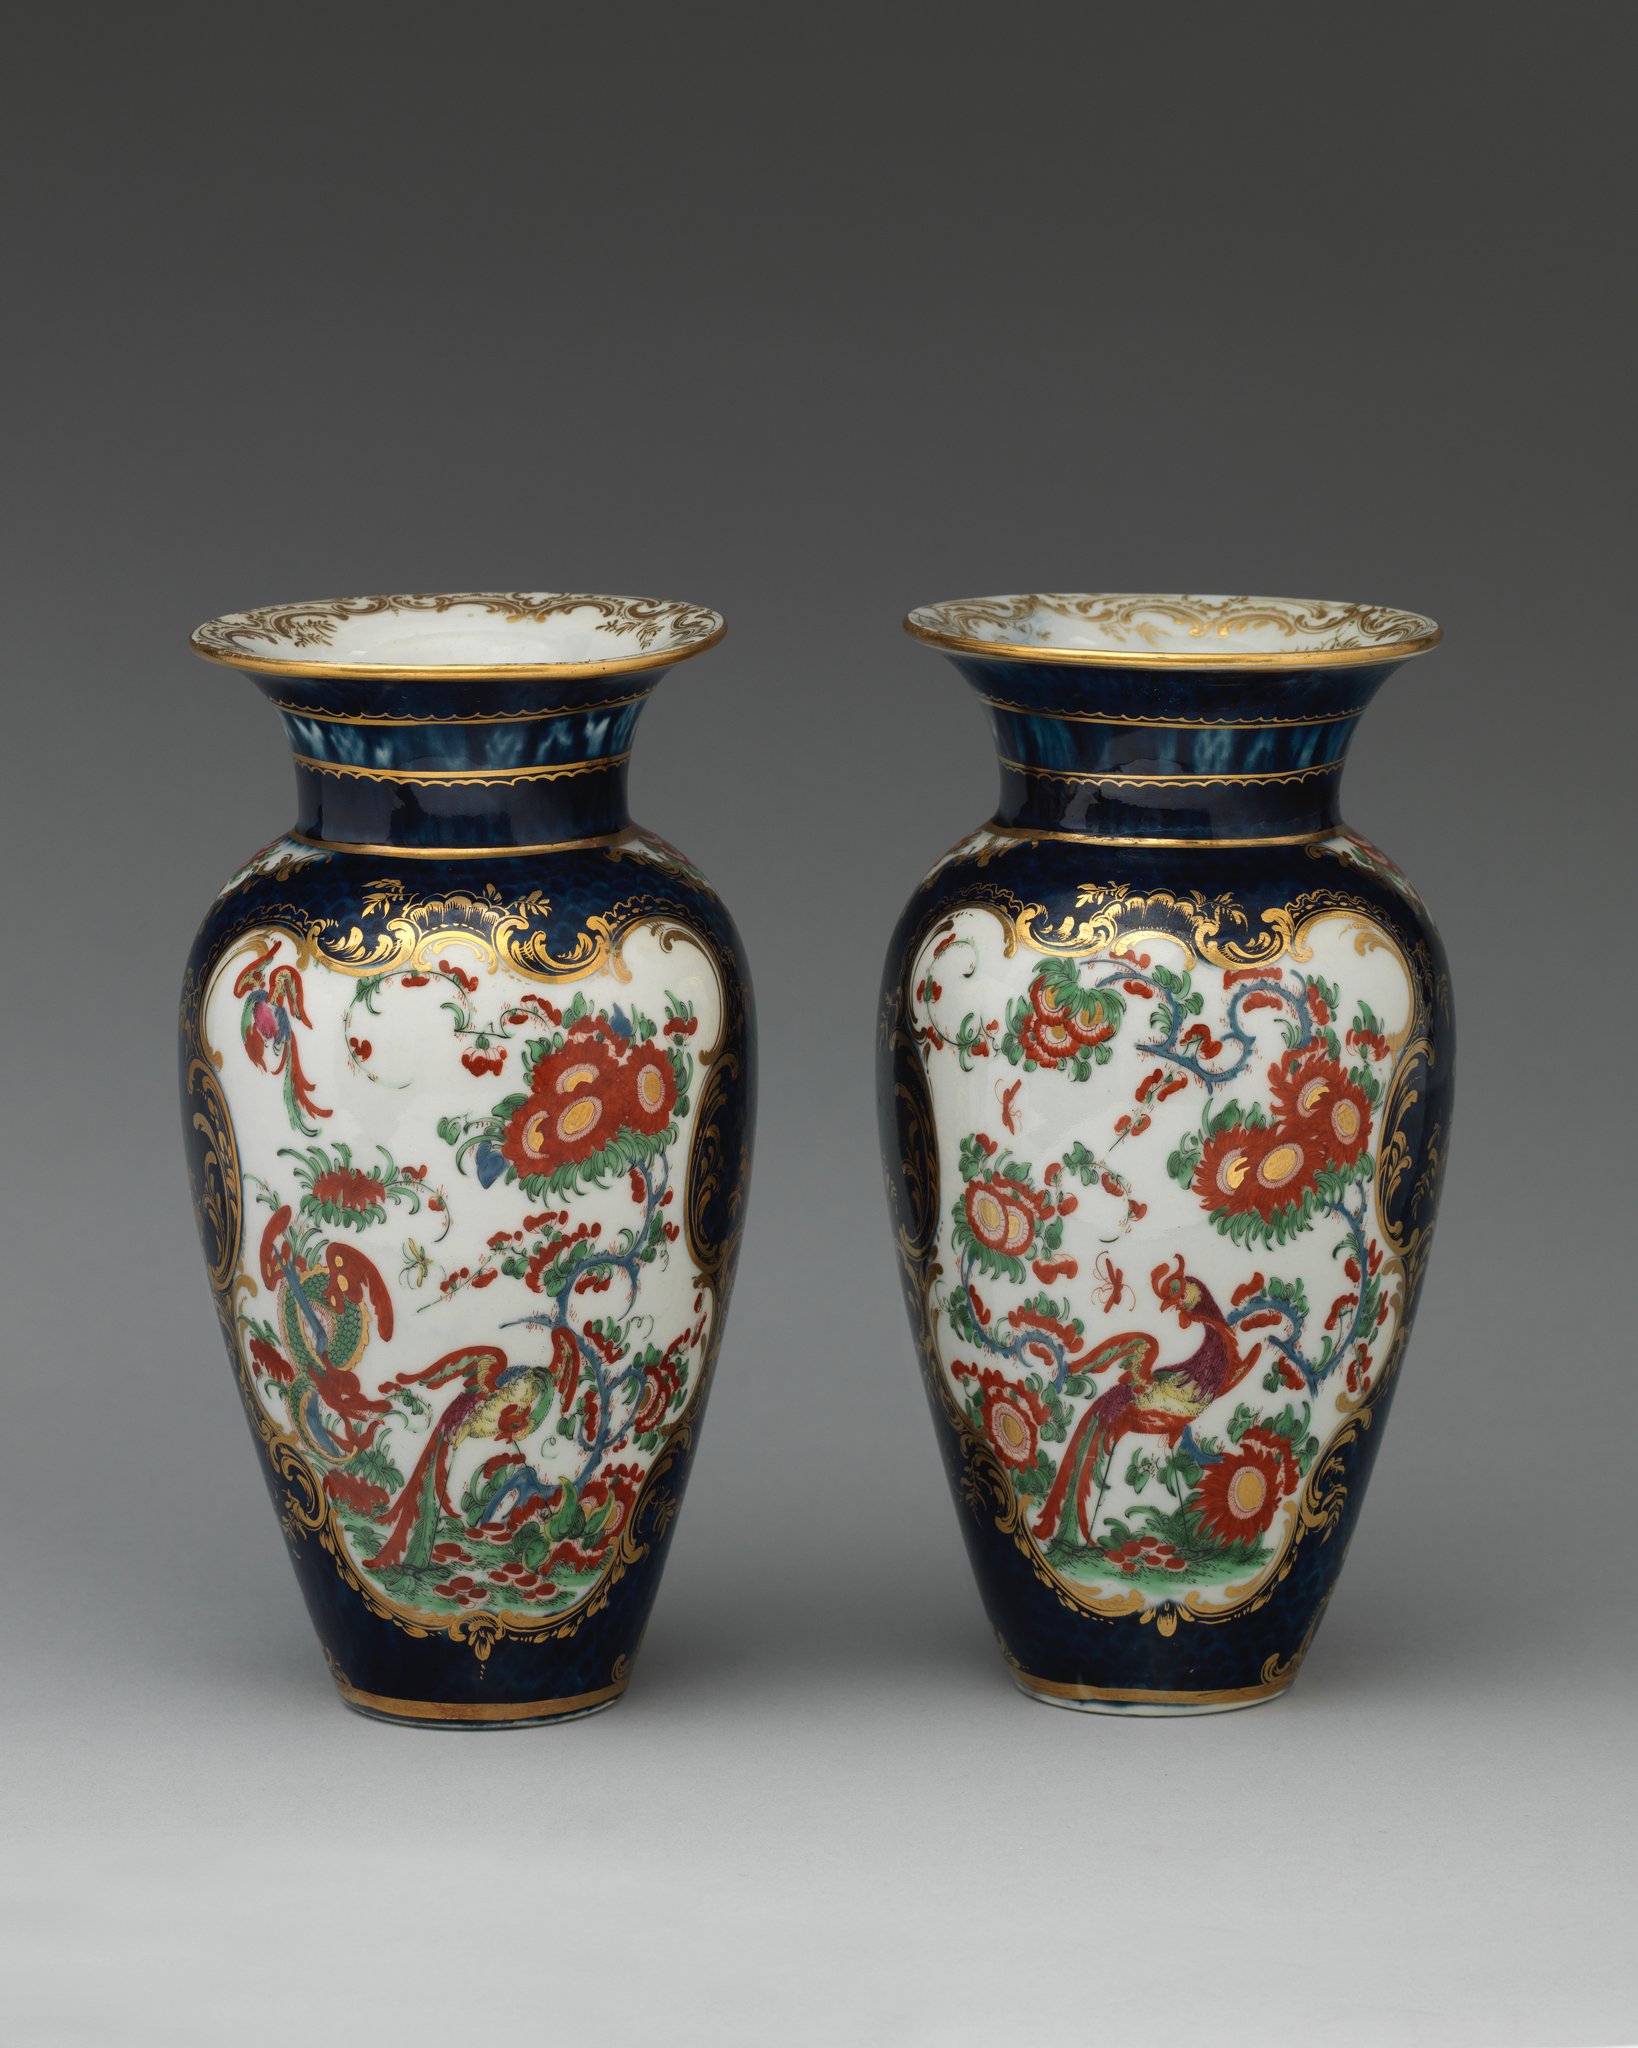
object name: vase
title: Pair of vases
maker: worcester factory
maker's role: factory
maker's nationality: british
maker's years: 1751-2008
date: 1770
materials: soft paste porcelain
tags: birds,flowers